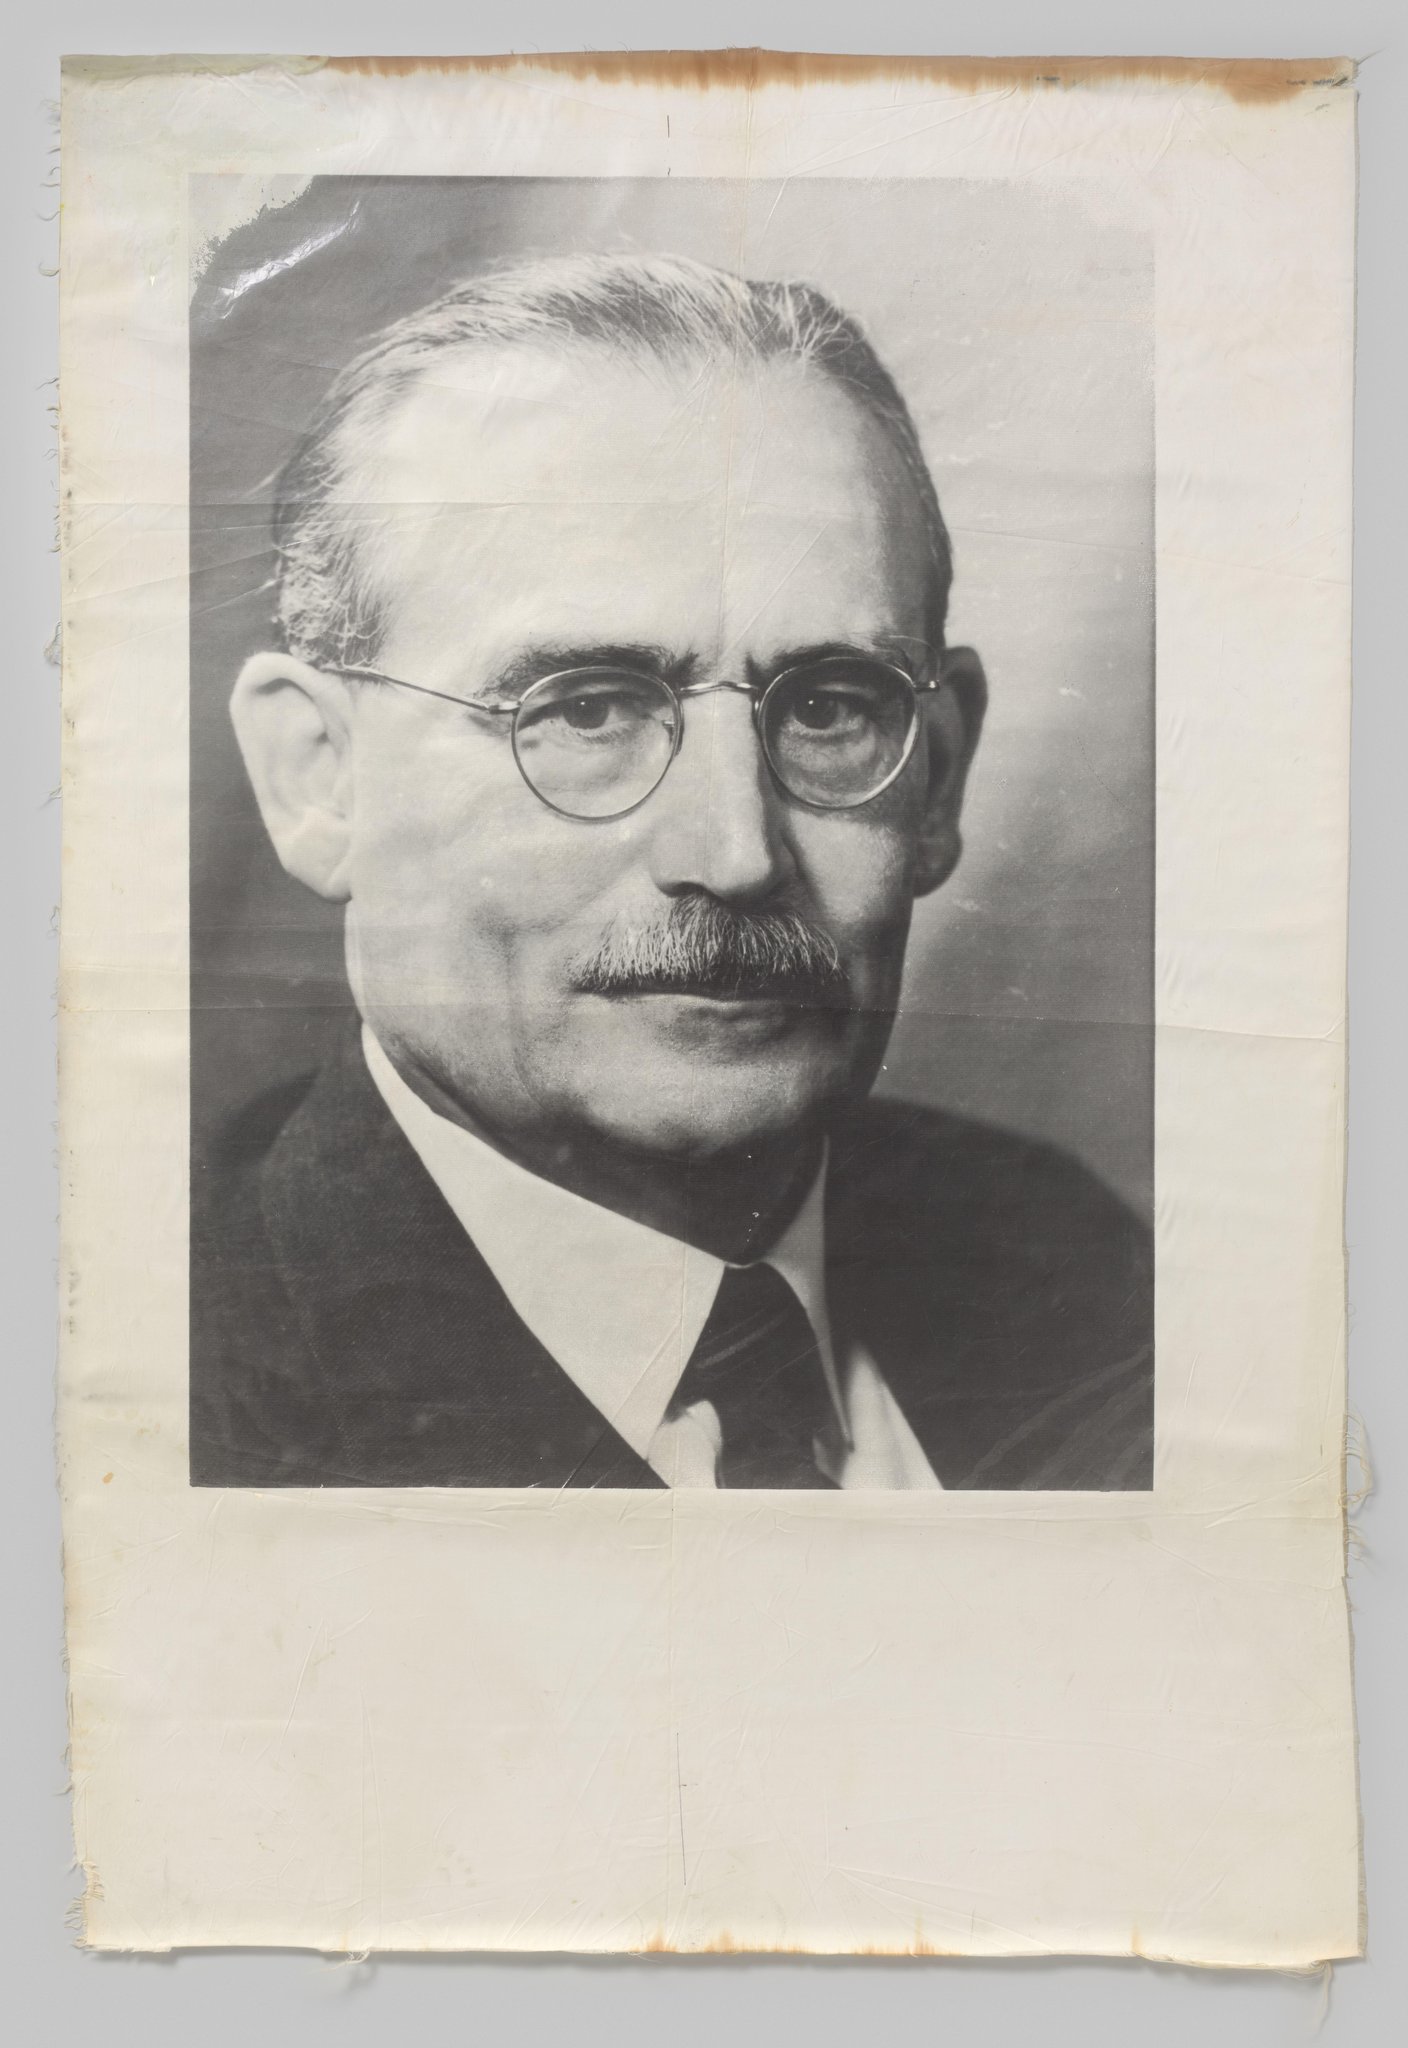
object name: photograph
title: Dr. Willem Drees afgedrukt op kunststof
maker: Anonymous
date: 1945-1960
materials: plastic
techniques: photography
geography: netherlands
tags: amsterdam, the hague, willem drees, historical persons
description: Vuilwit kunststof doek waarop in de vorm van een dun plastic laagje een gezichtsportret van Drees is afgedrukt. Bovenrand bruingeel verkleurd. Foto is zwartwit, de linkerbovenhoek is weggesleten.